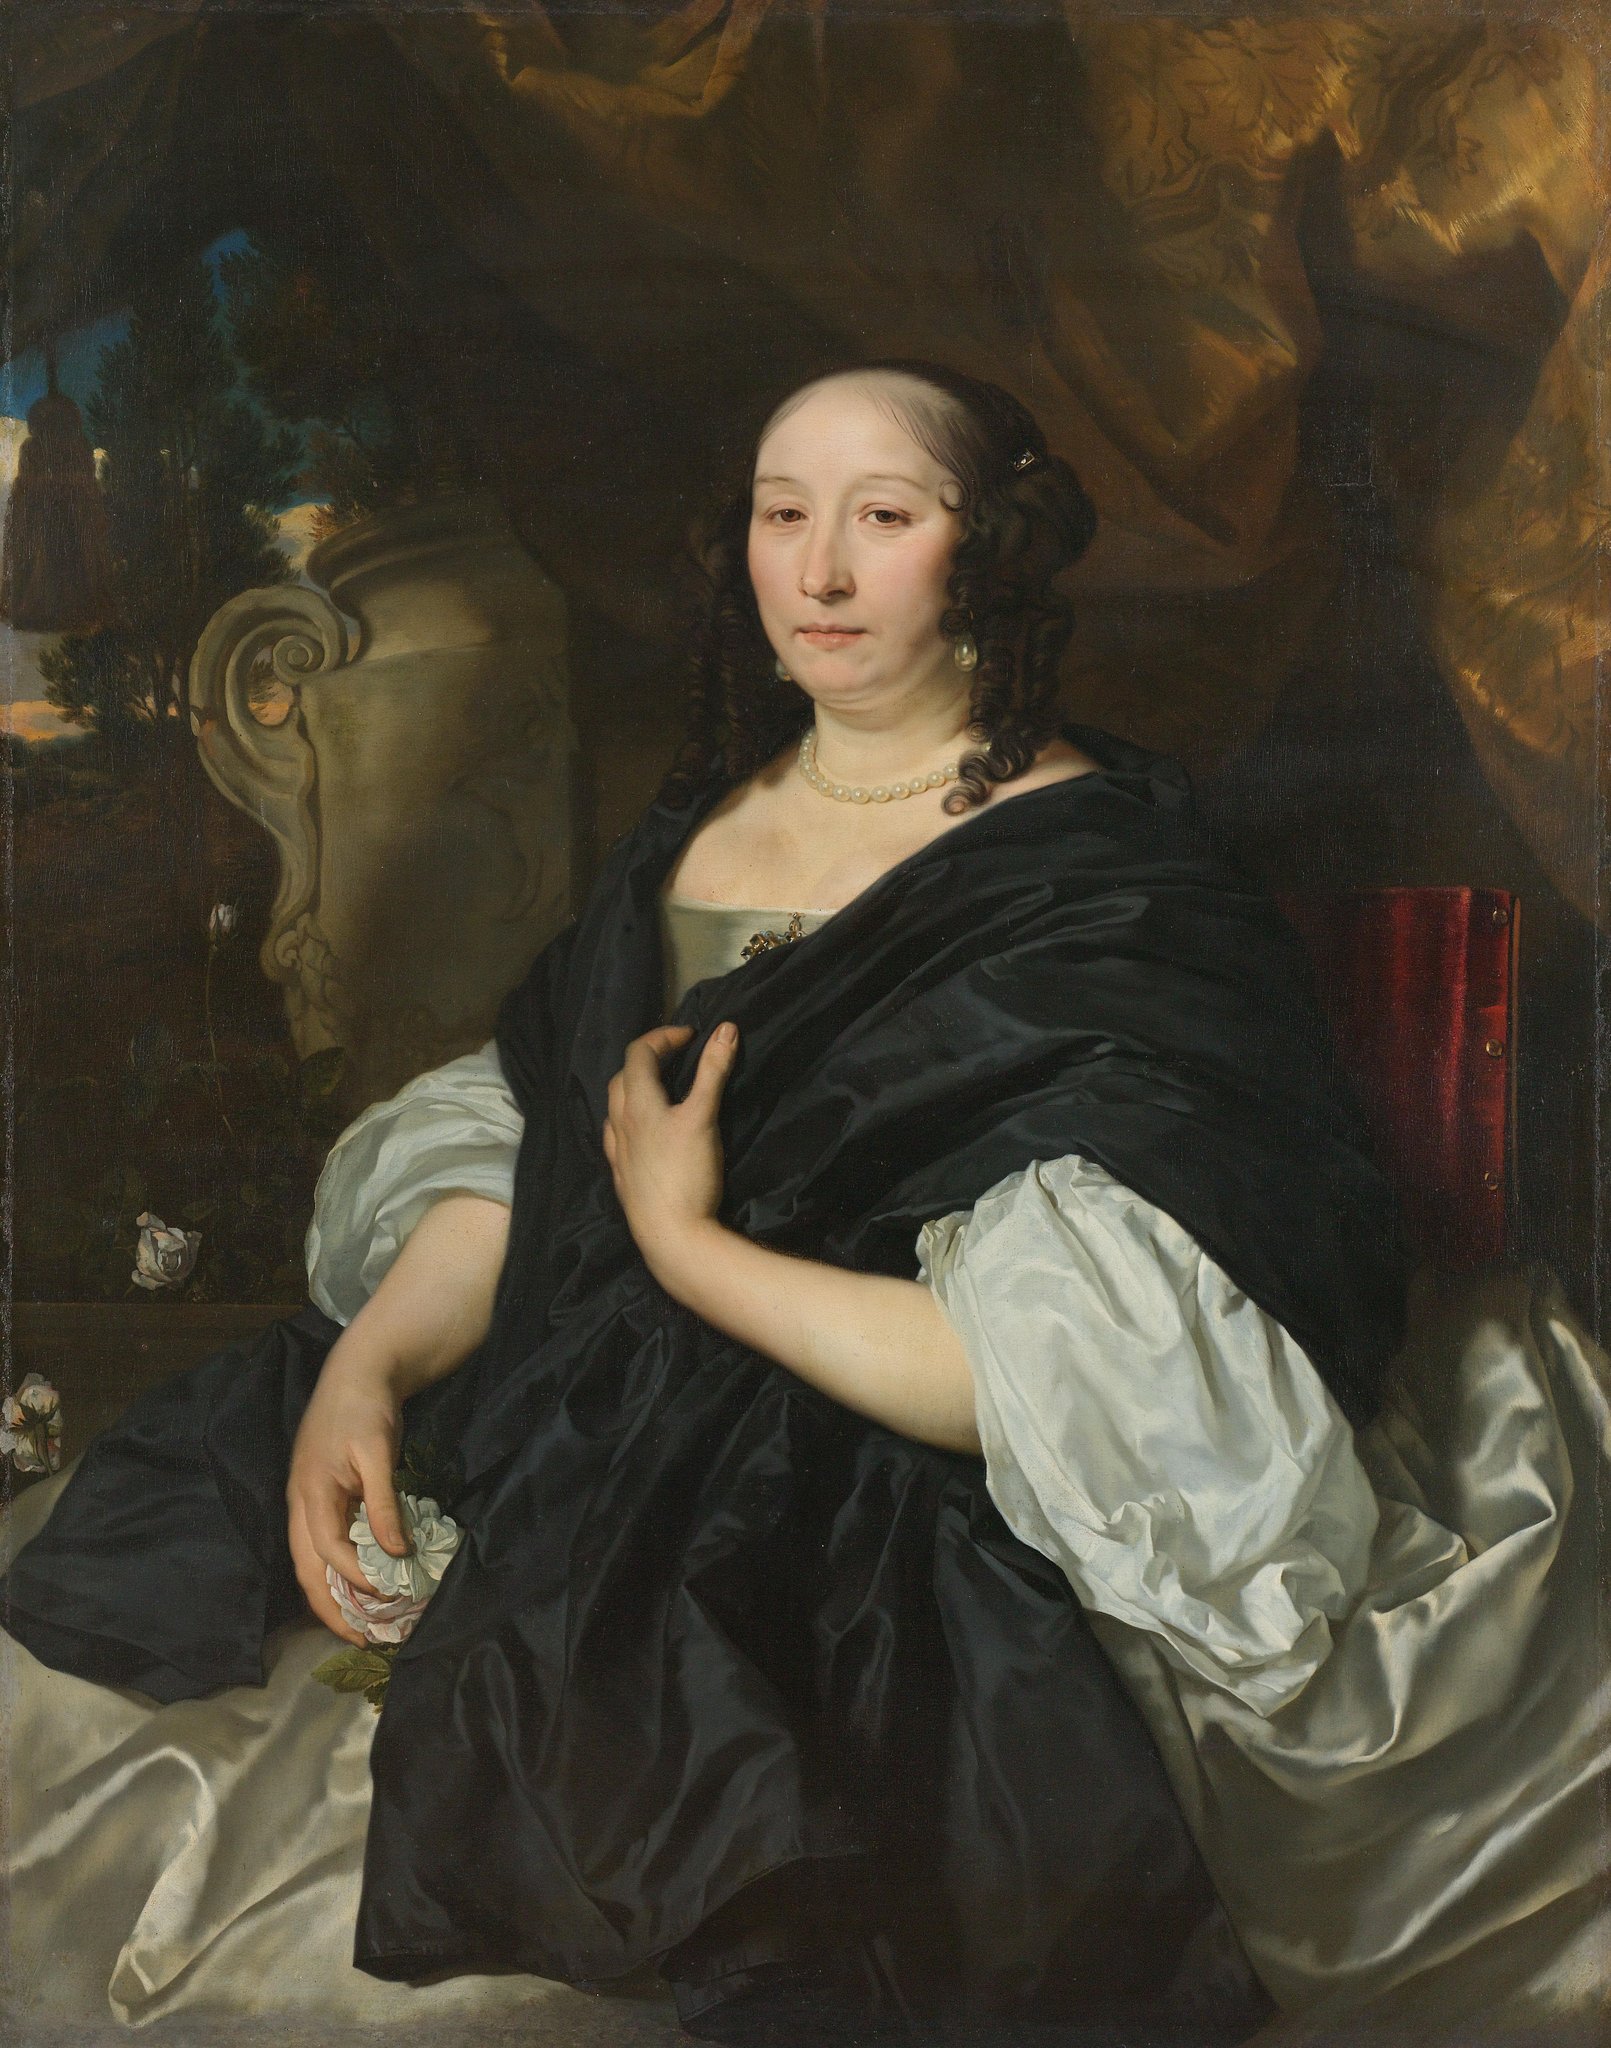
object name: painting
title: Catharina van der Voort (1622-74). Second wife of Pieter de la Court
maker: abraham van den tempel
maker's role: draughtsman, painter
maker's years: 1622-1672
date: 1667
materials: canvas, oil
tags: historical persons - bb - woman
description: Catharina’s wealth radiates from this portrait. Van den Tempel positioned her before a balustrade, near a rosebush. Adorned with pearls and other costly jewels, she literally spreads her wealth before our eyes: the voluminous folds of her sumptuous gown extend across the full width of the painting, giving her an imposing air.